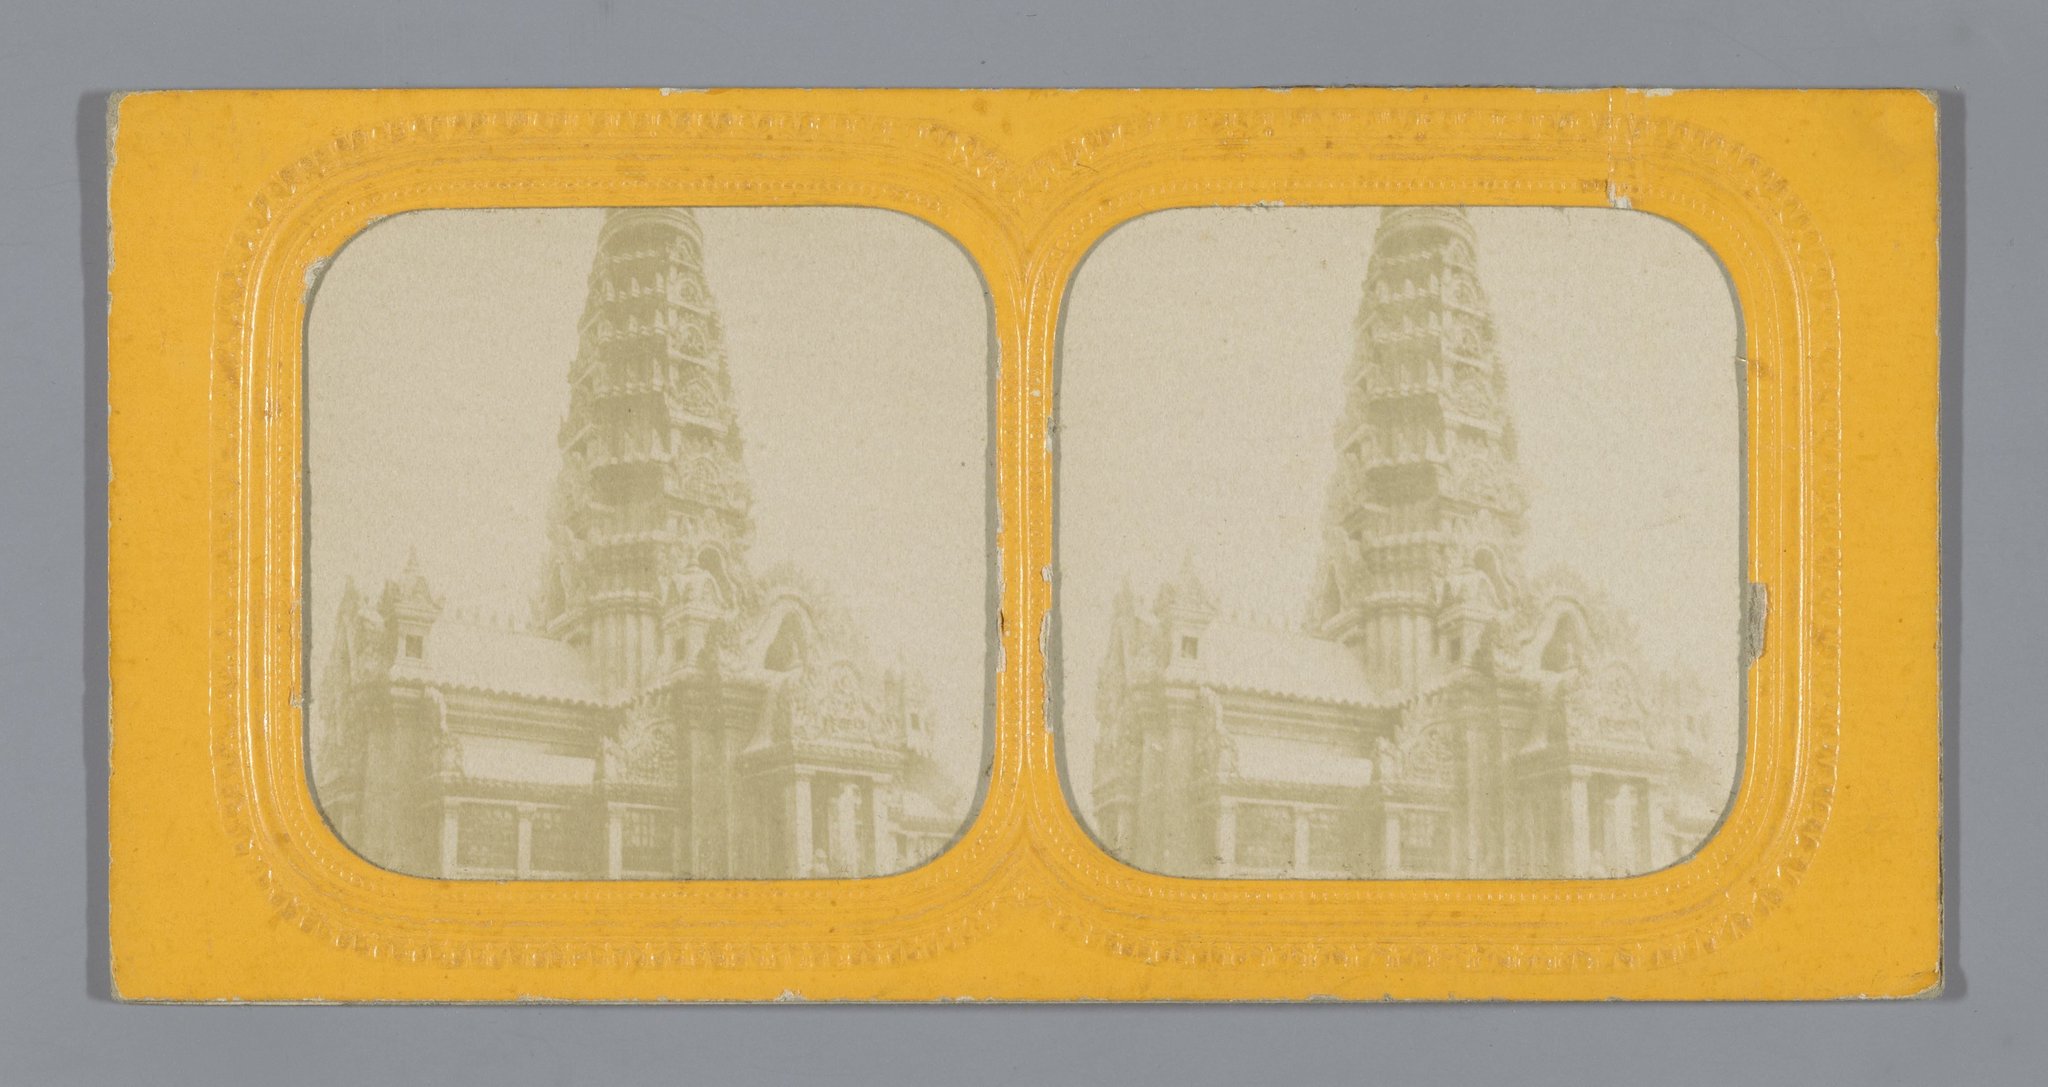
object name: tissue stereograph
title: Chineesche tempel op de Parijsche tentoonstelling, 1889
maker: Anonymous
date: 1889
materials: cardboard, paper, photographic support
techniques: albumen print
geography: paris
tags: temple, shrine ~ traditional chinese religions, paris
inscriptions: number: ‘No 21’